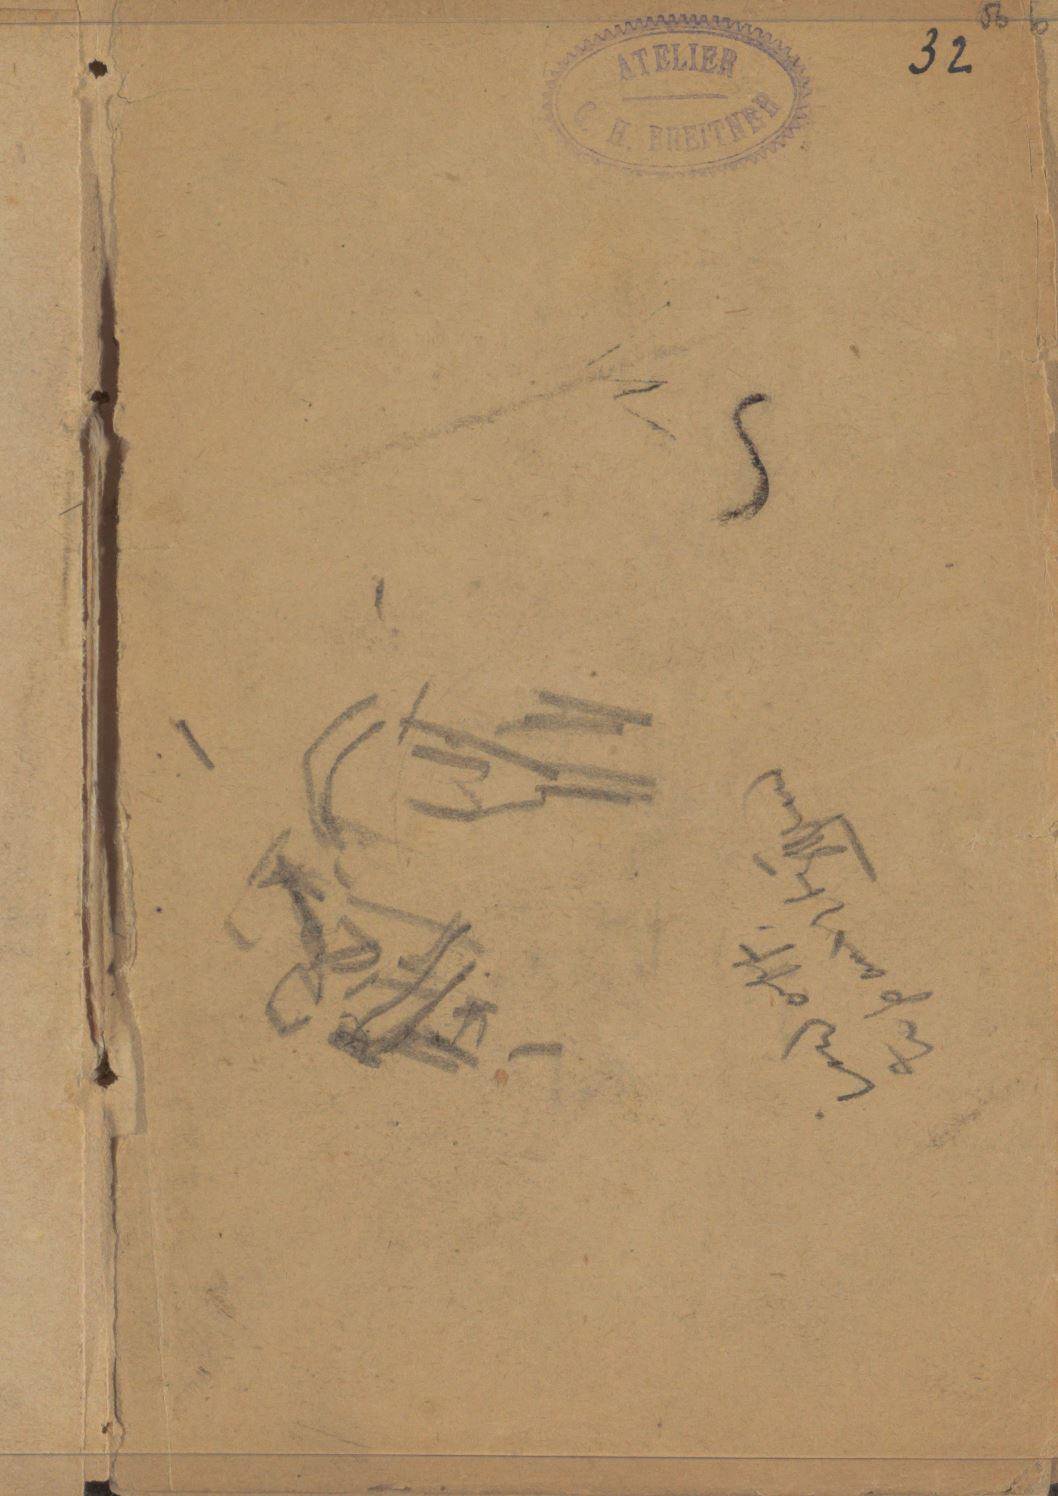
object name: sketchbook leaf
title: Officier te paard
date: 1887-1891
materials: paper, pencil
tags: land forces (+ officers), horse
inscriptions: annotation: ‘inf[?] off./ te paard stijgen’, workshop stamp: Lugt 291d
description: Pagina 56 uit een schetsboek met 83 bladen.